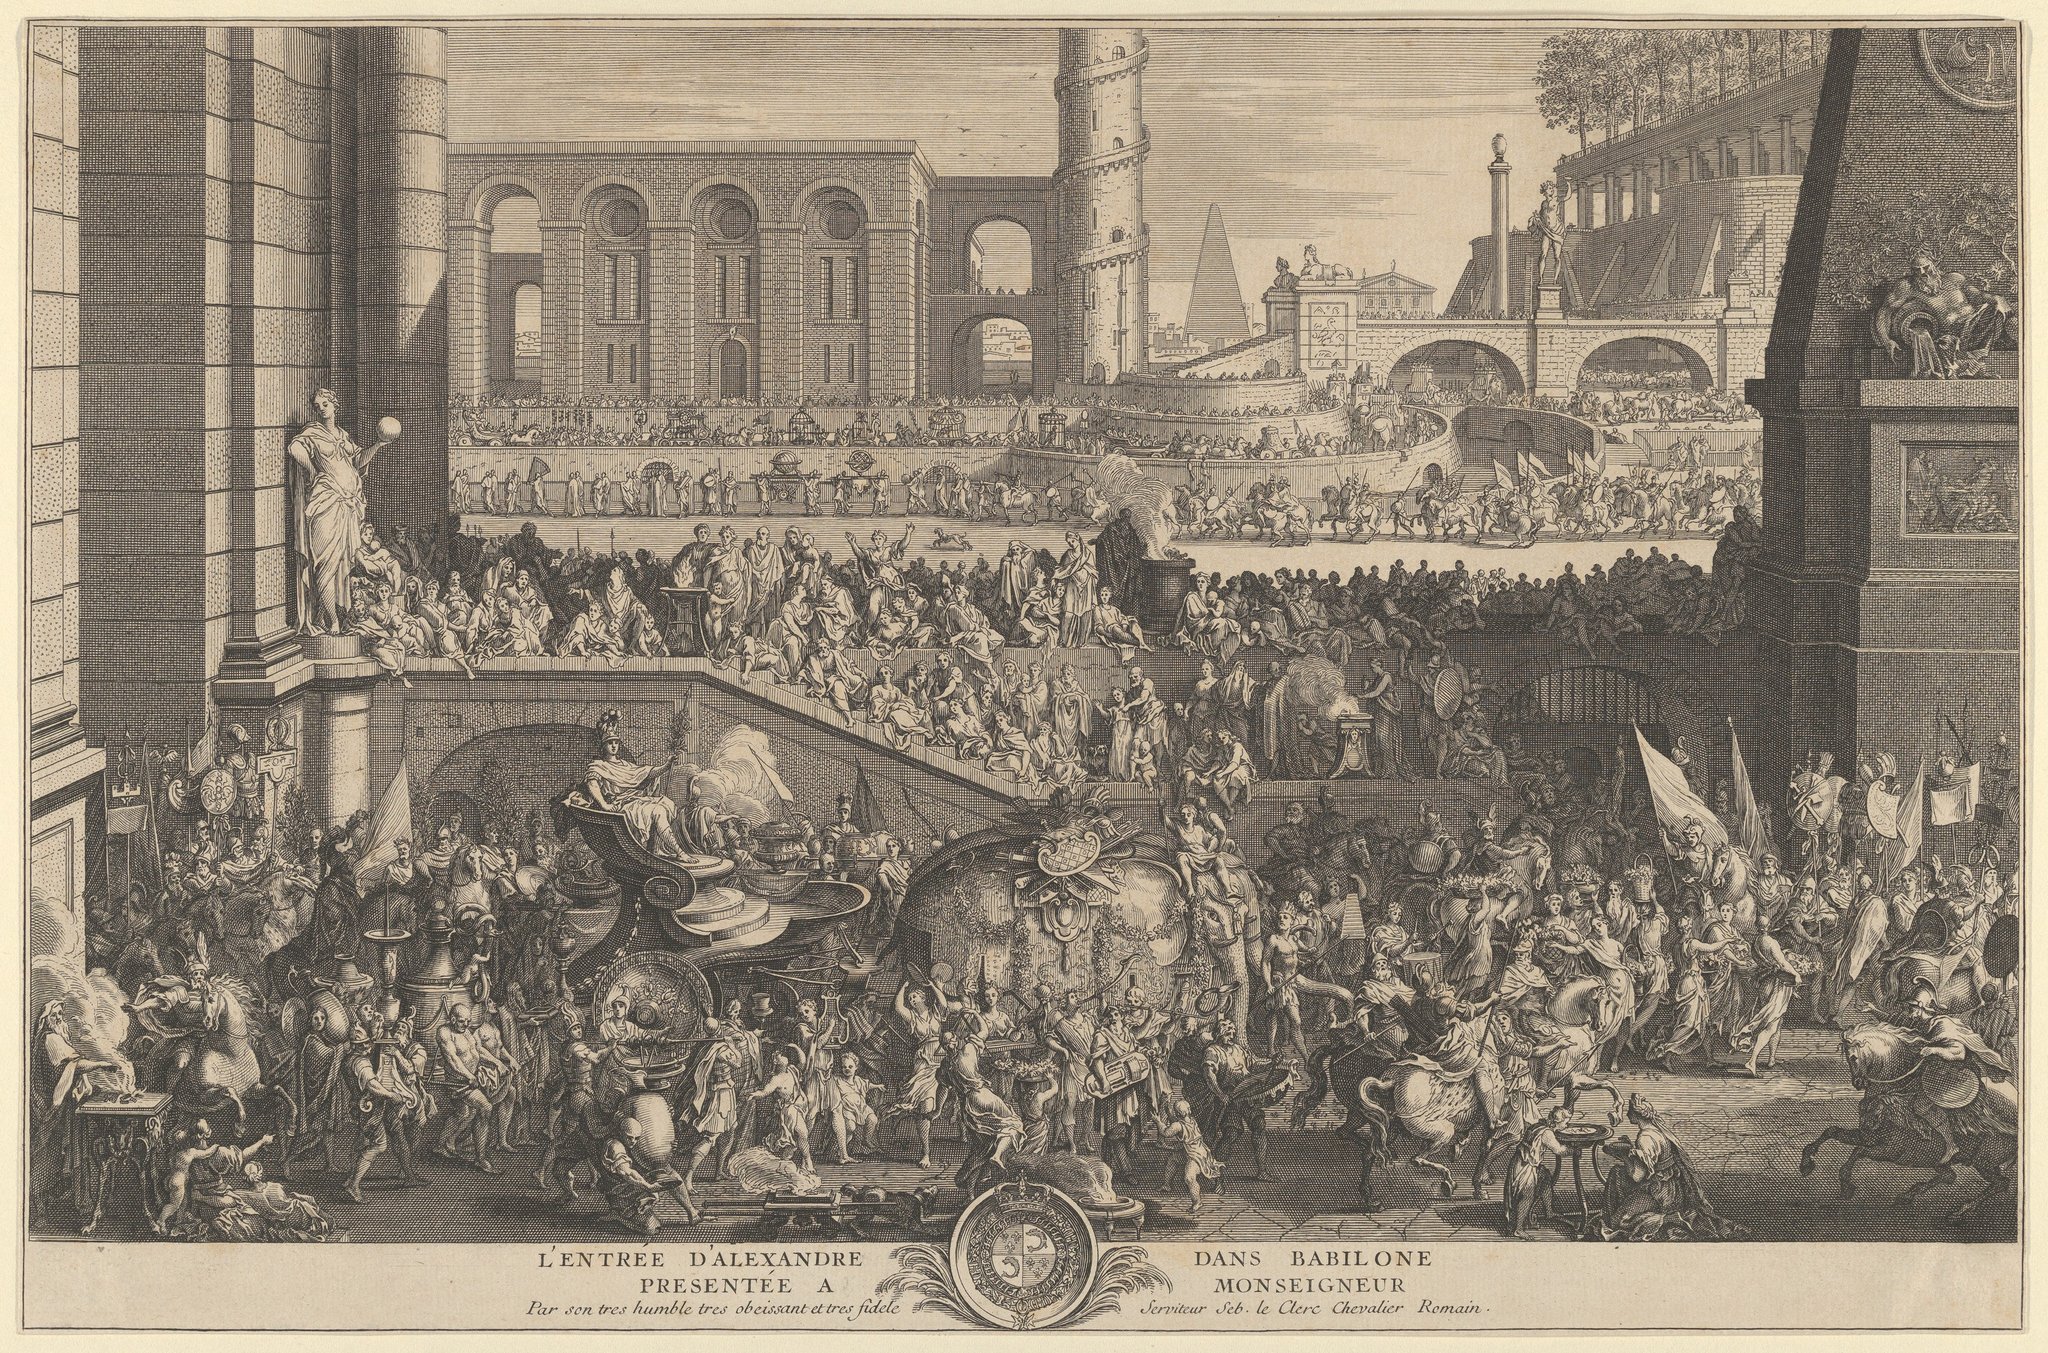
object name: print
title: The Entry of Alexander into Babylon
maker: sébastien leclerc (i)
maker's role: artist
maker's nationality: french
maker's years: 1637-1714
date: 1704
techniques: etching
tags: alexander the great,elephants,horses,crowd,chariots